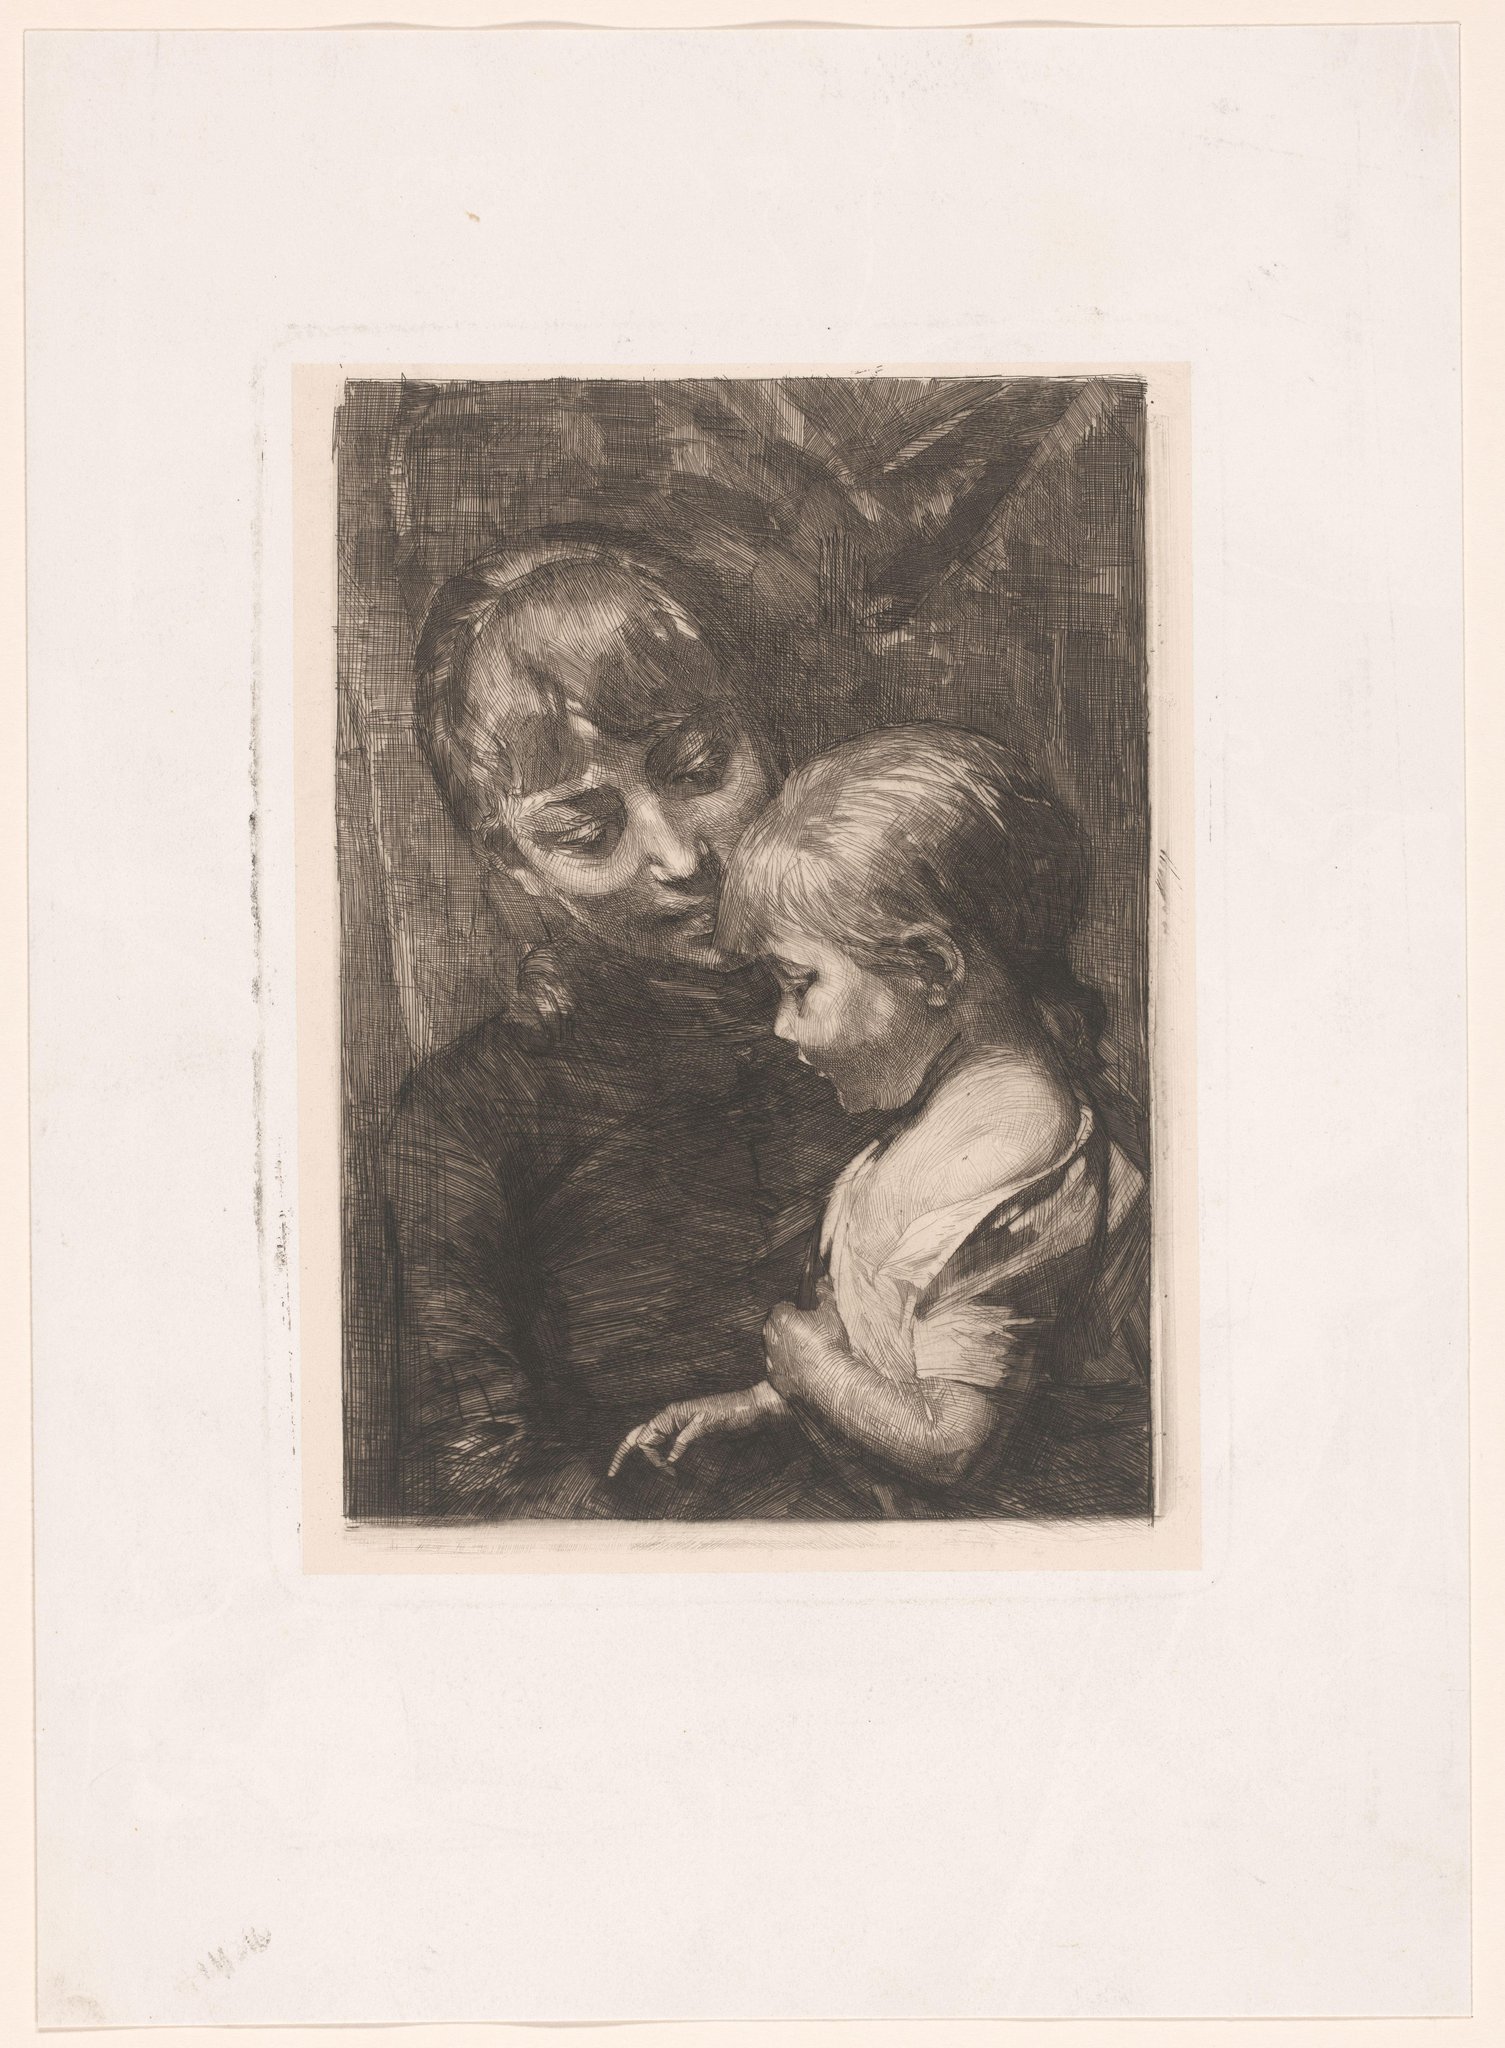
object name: print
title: Vrouw met kind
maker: nicolaas van der waay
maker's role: draughtsman, painter, print maker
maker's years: 1855-1936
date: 1865-1936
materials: paper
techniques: drypoint, etching, intaglio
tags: mother and child(ren), woman and child(ren) (family group)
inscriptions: collector's mark: Lugt 2228, collector's mark: Lugt 2760